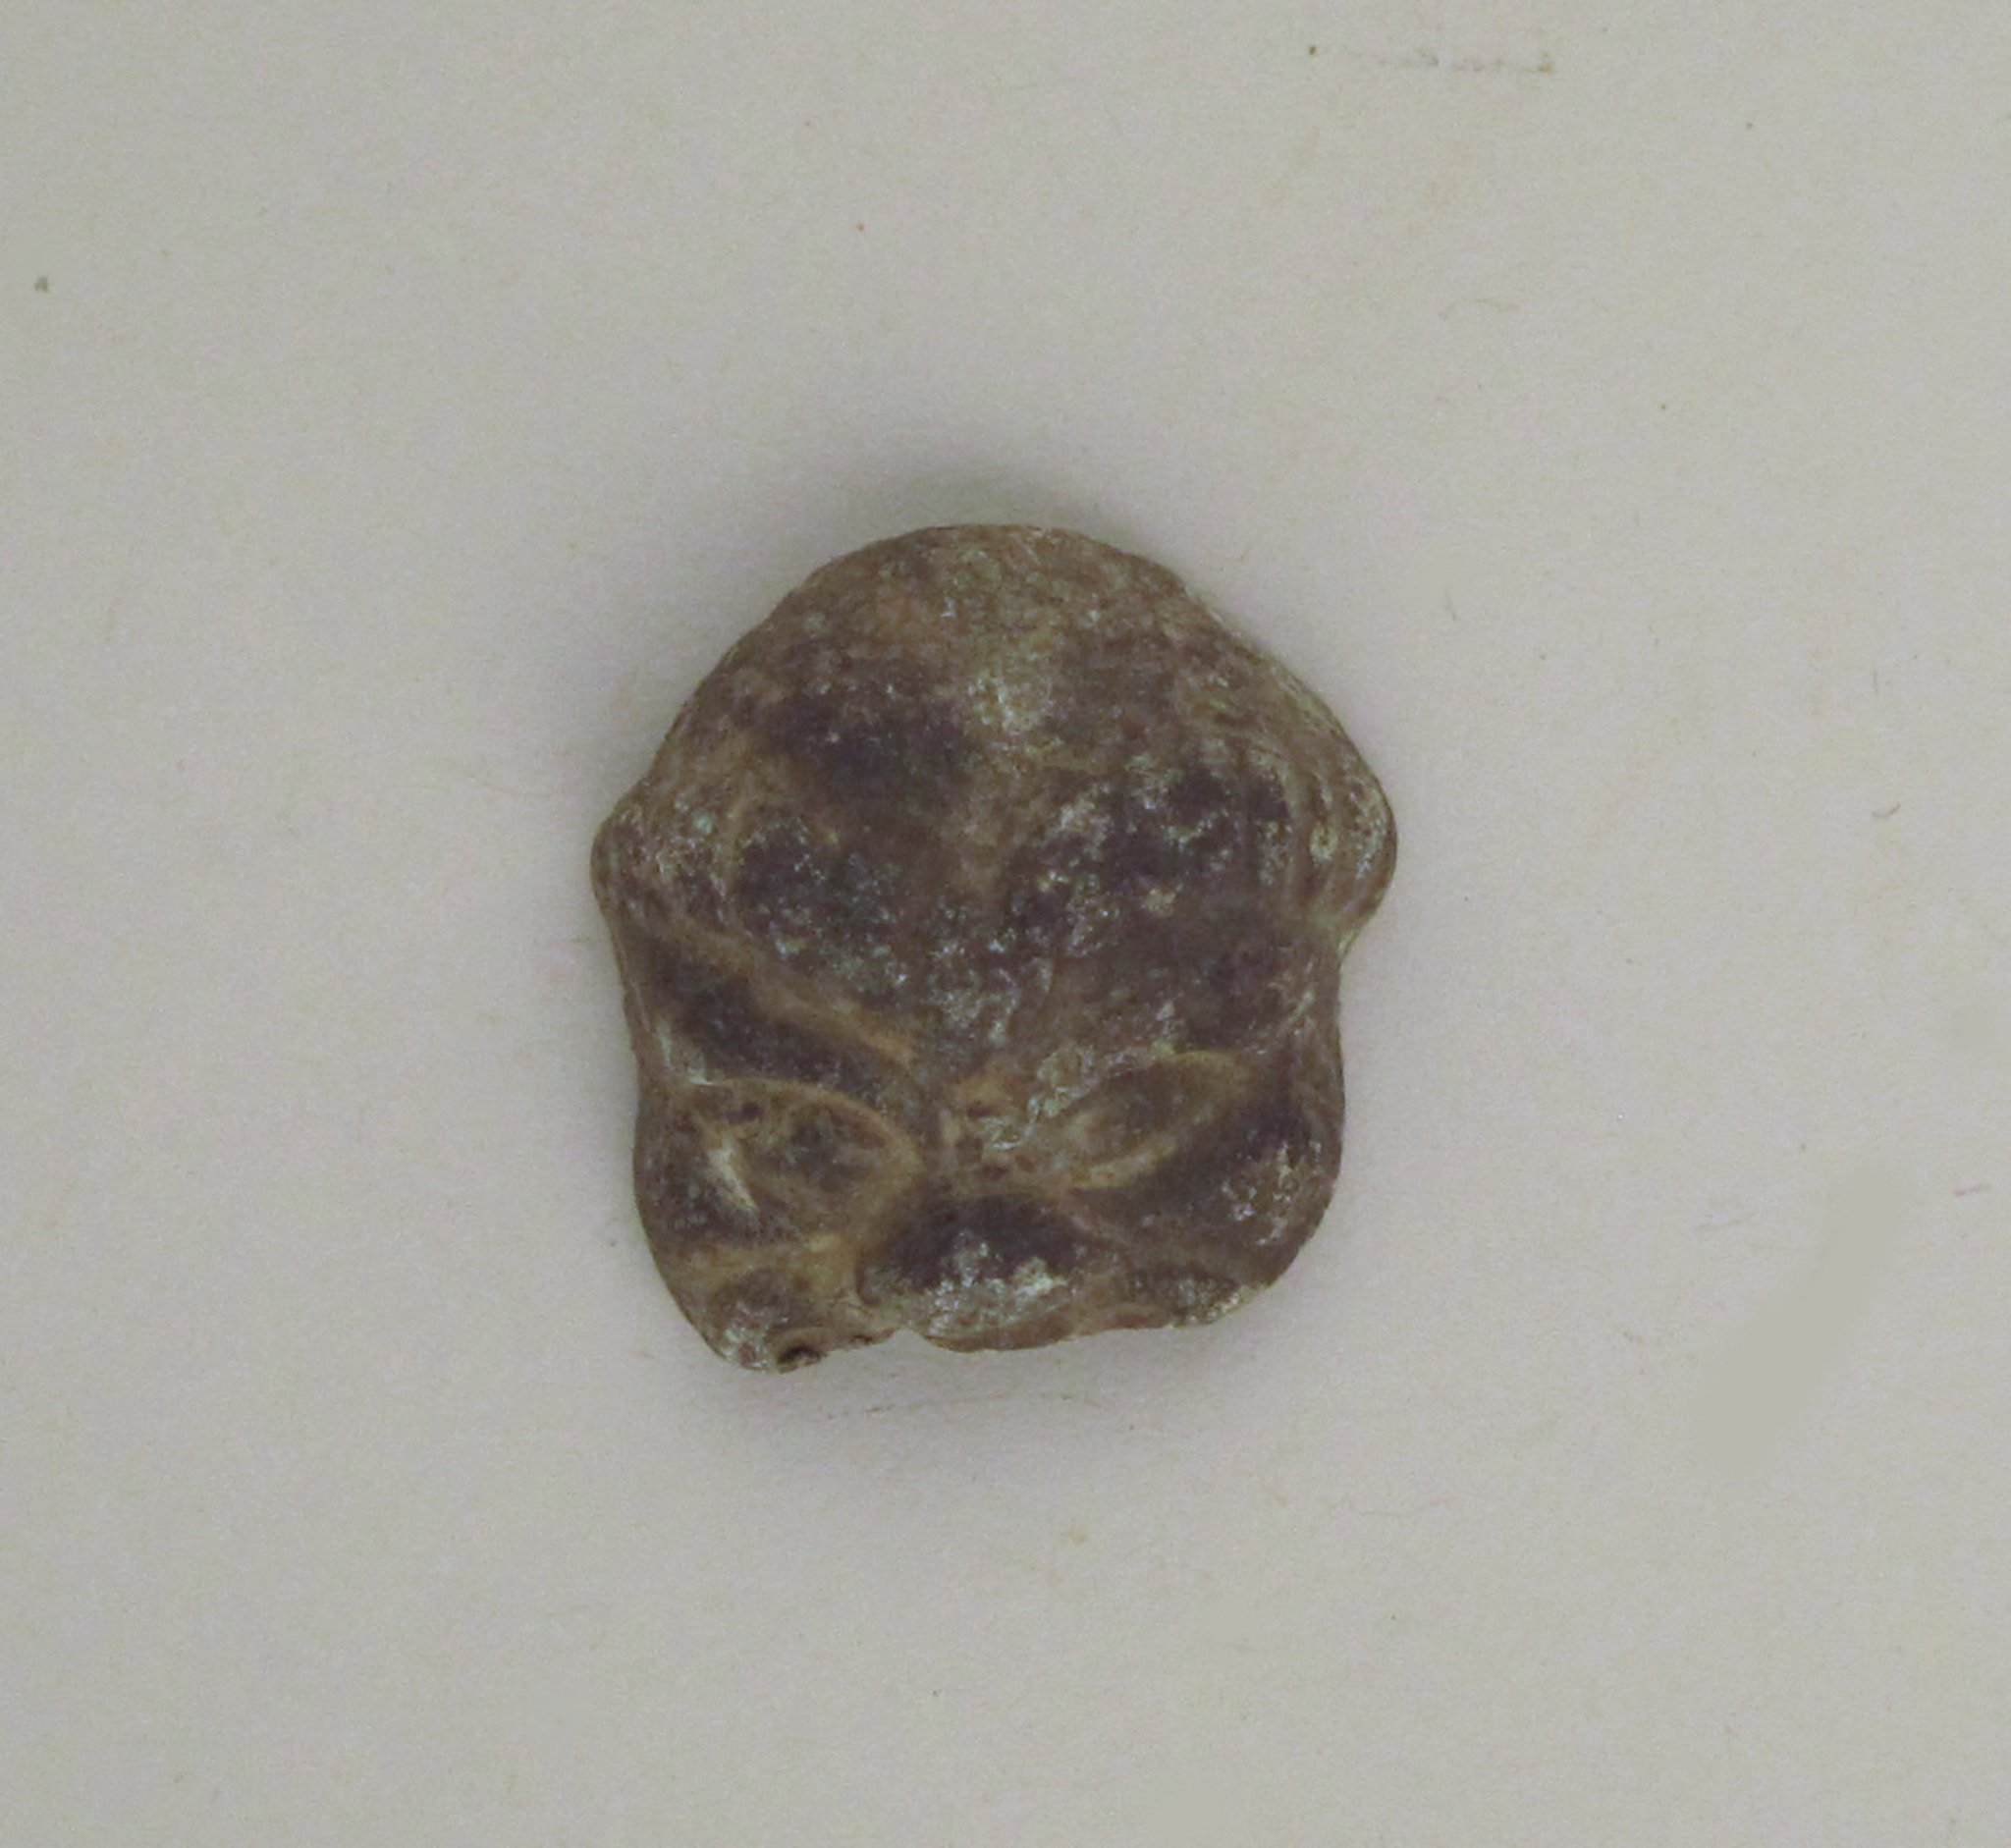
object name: mask of a satyr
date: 7000 BCE-330 CE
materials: lead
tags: masks,satyrs